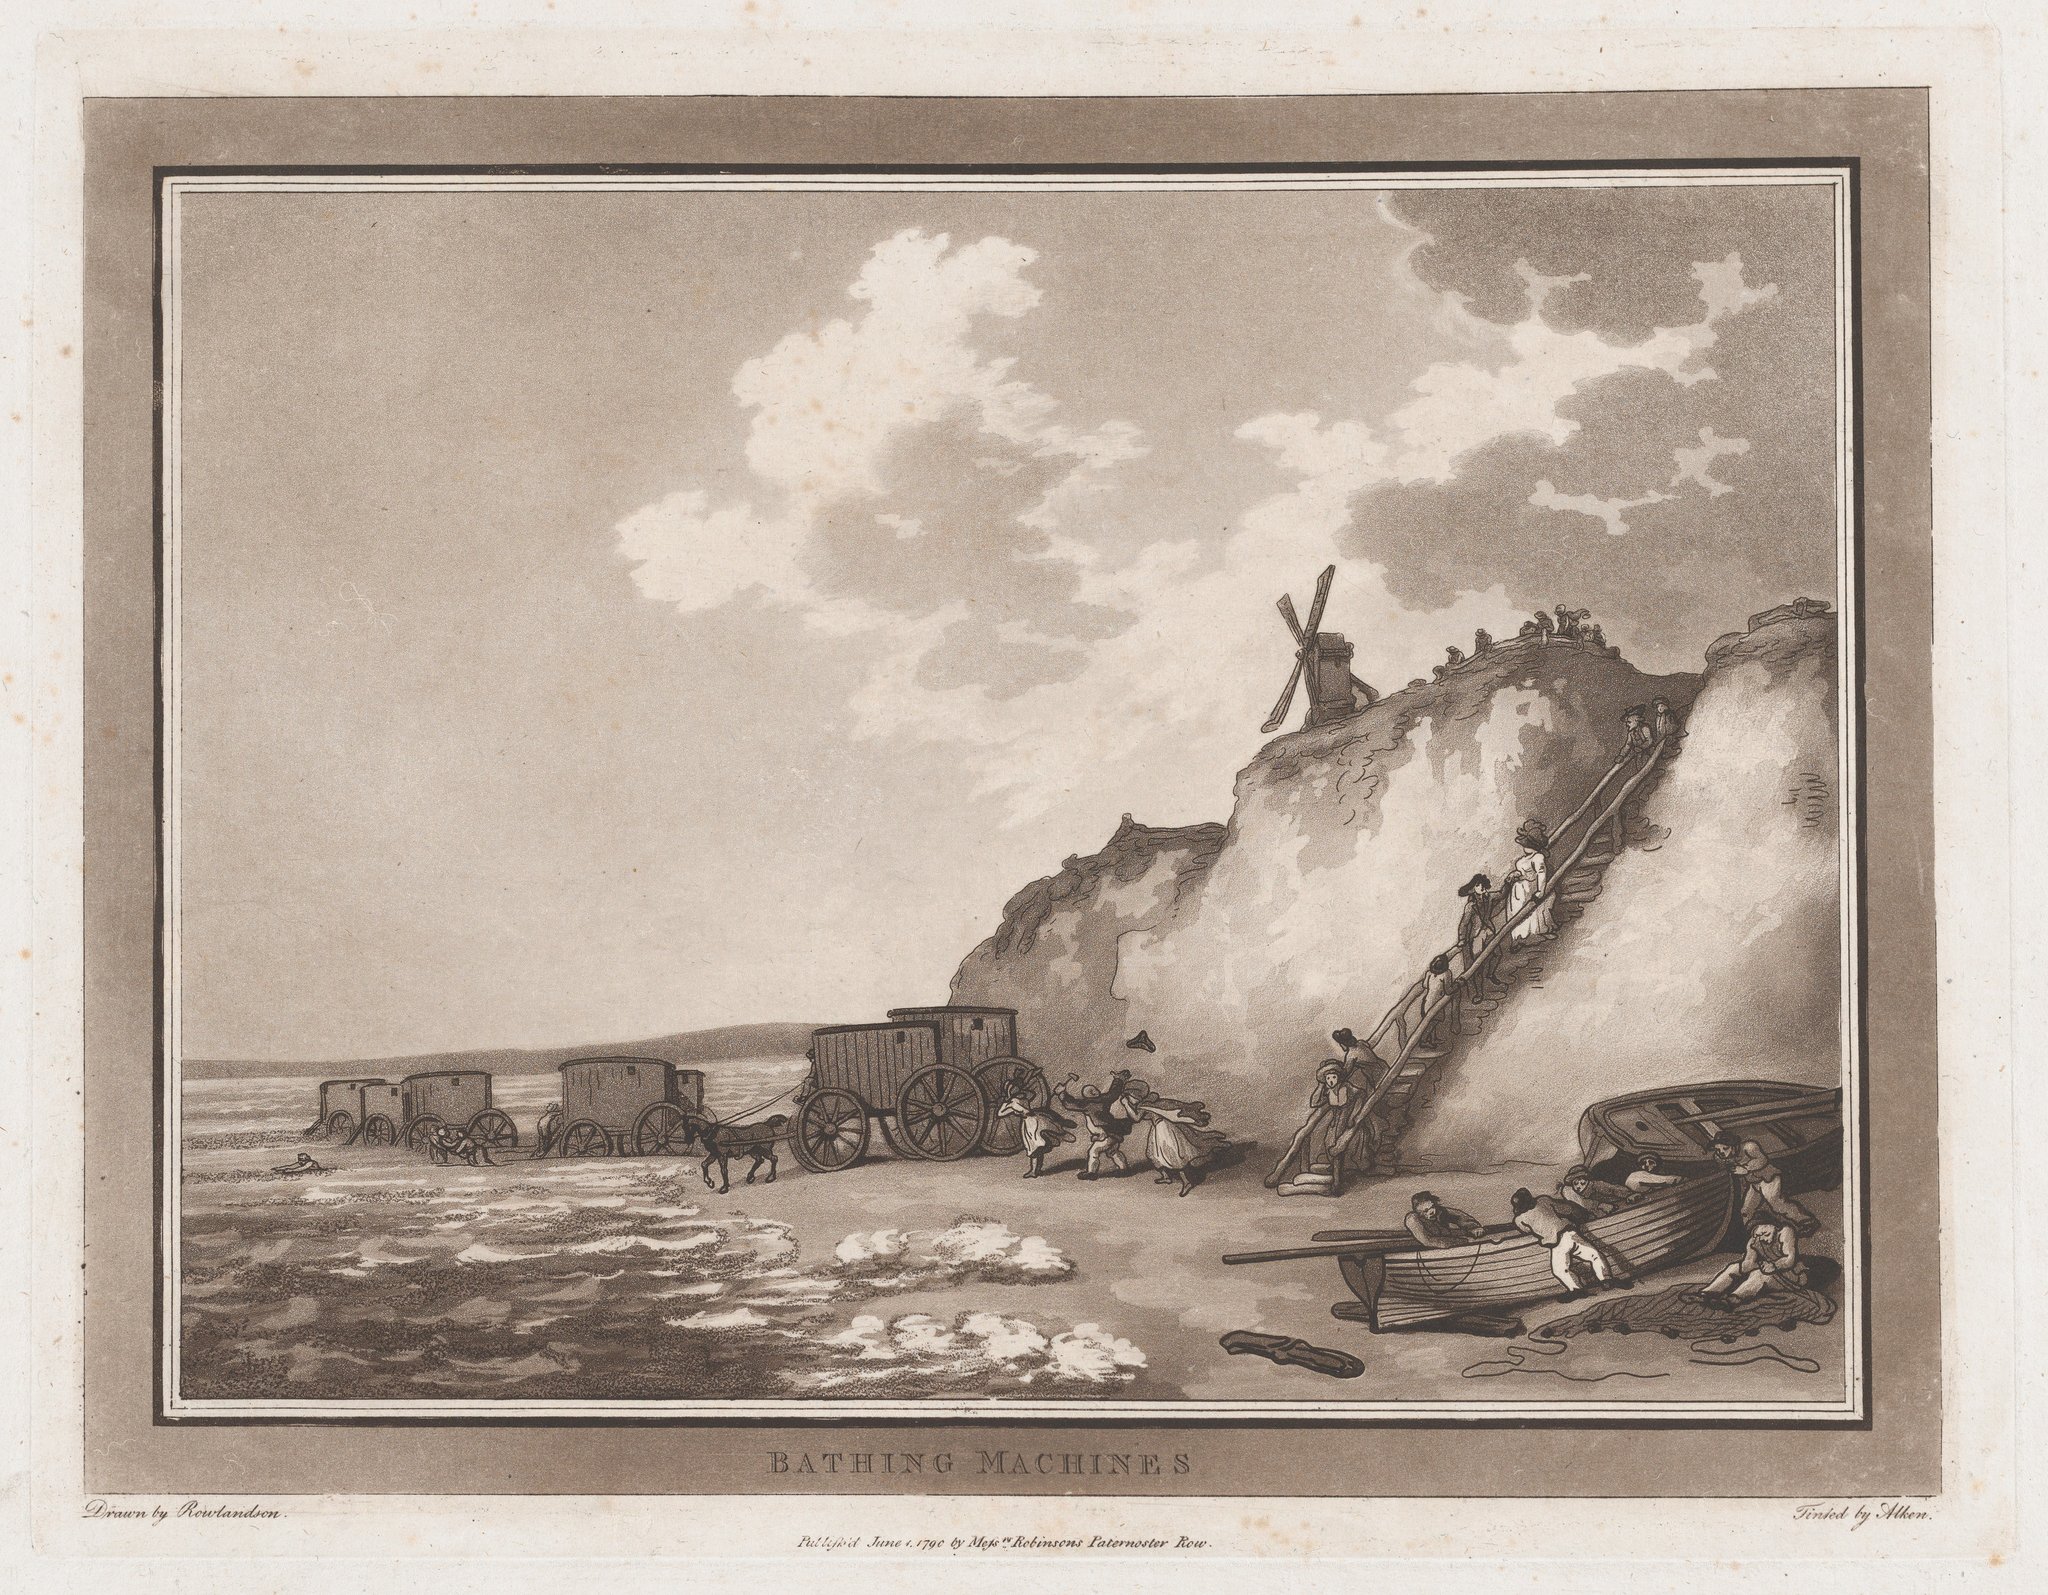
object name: print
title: Bathing Machines (An Excursion to Brighthelmstone)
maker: thomas rowlandson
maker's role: artist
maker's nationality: british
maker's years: 1757-1827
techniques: etching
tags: human figures,horses,beaches,carriages